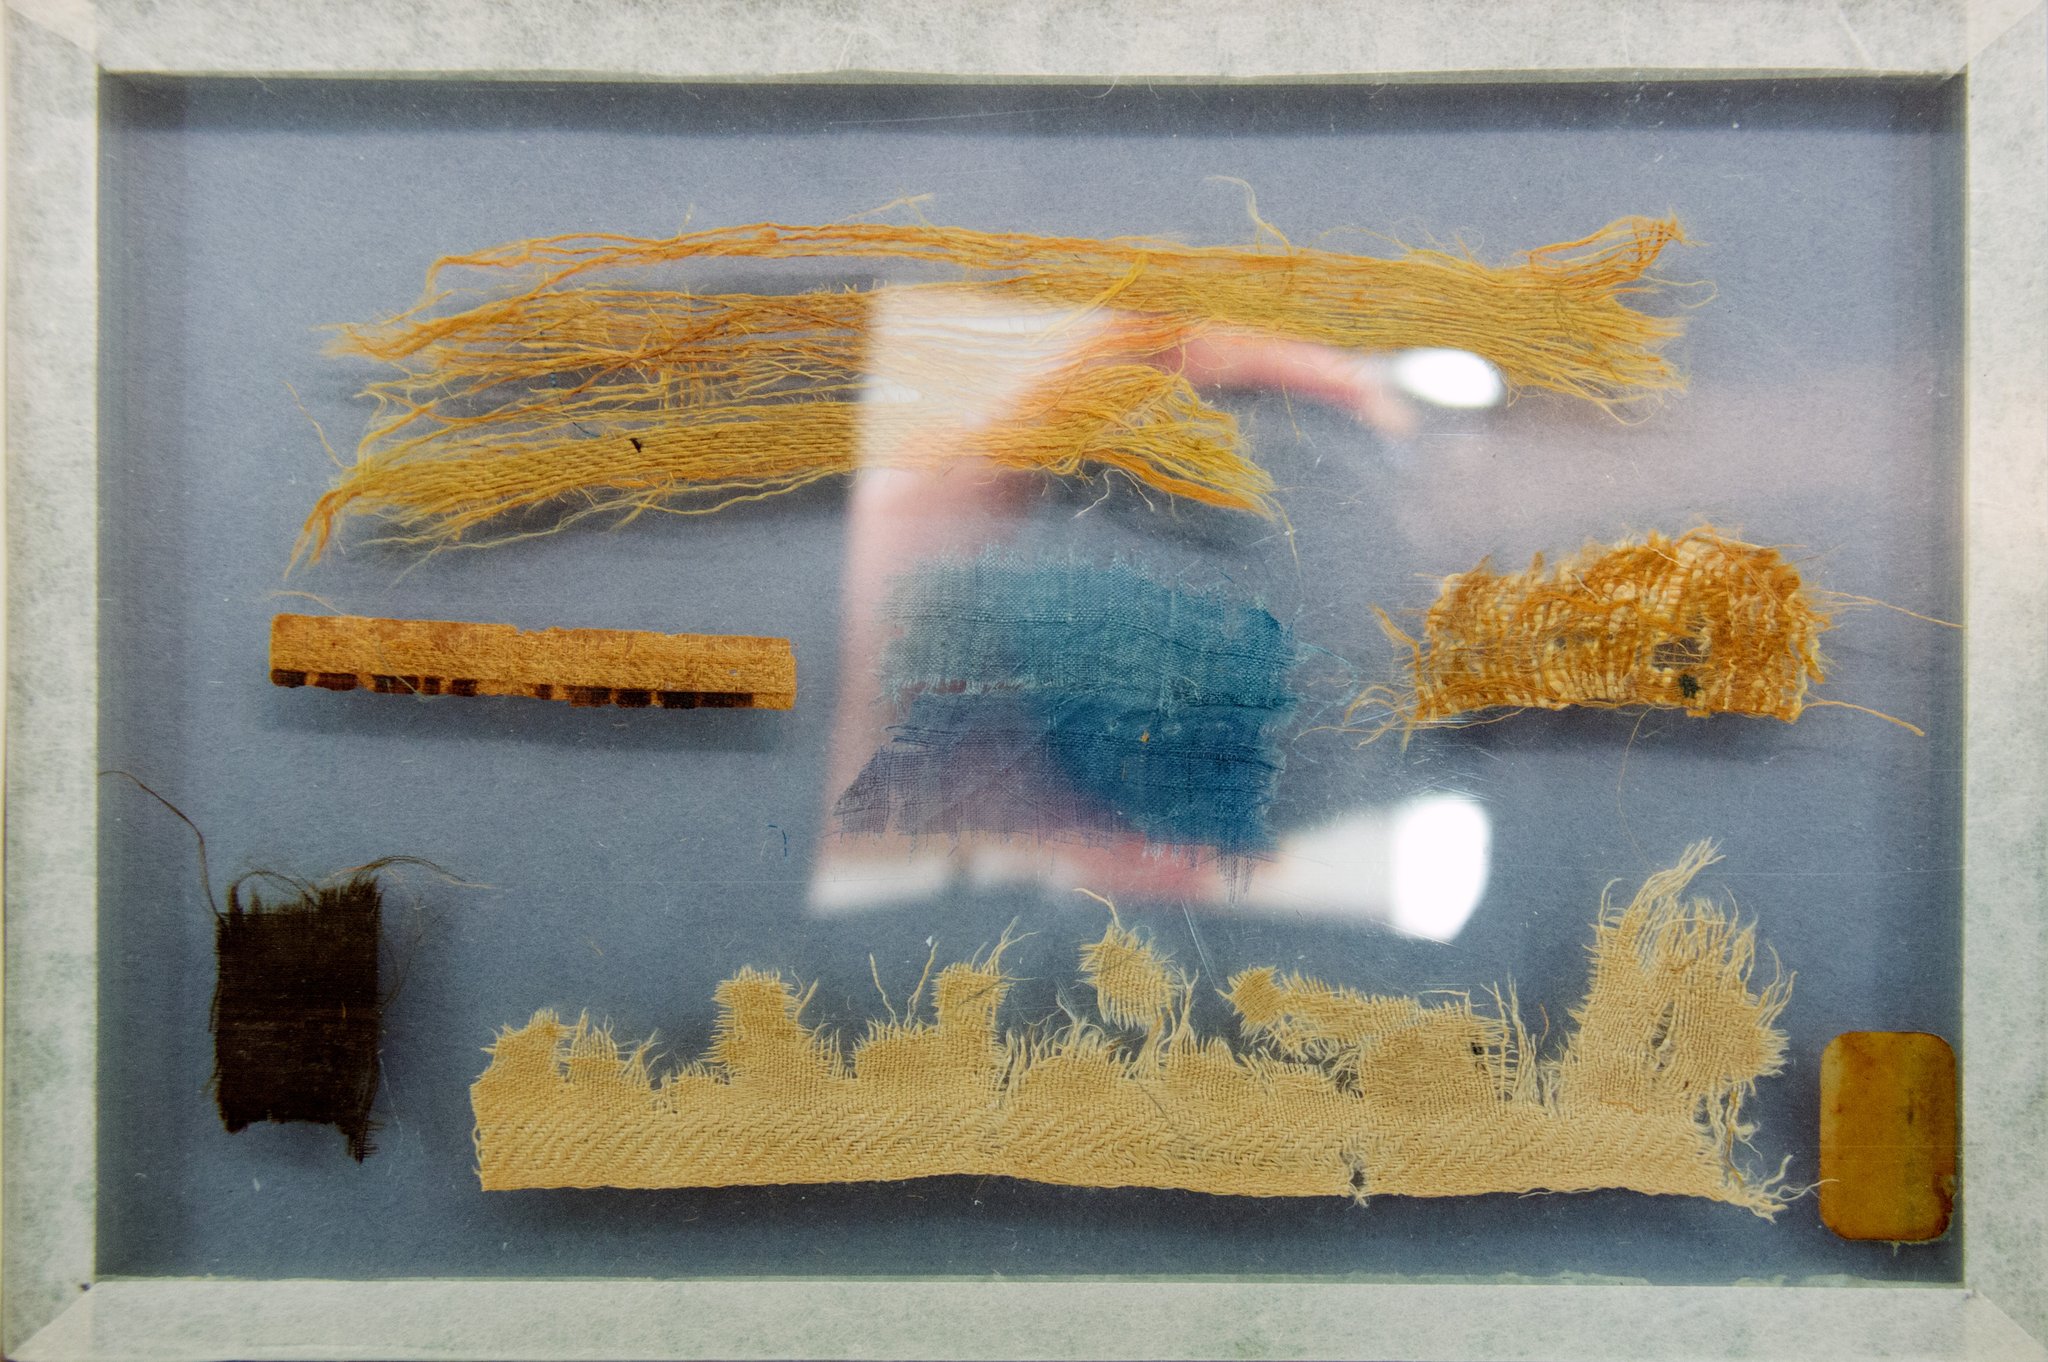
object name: fragment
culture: japanese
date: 701-800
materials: cotton, linen, silk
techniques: weave